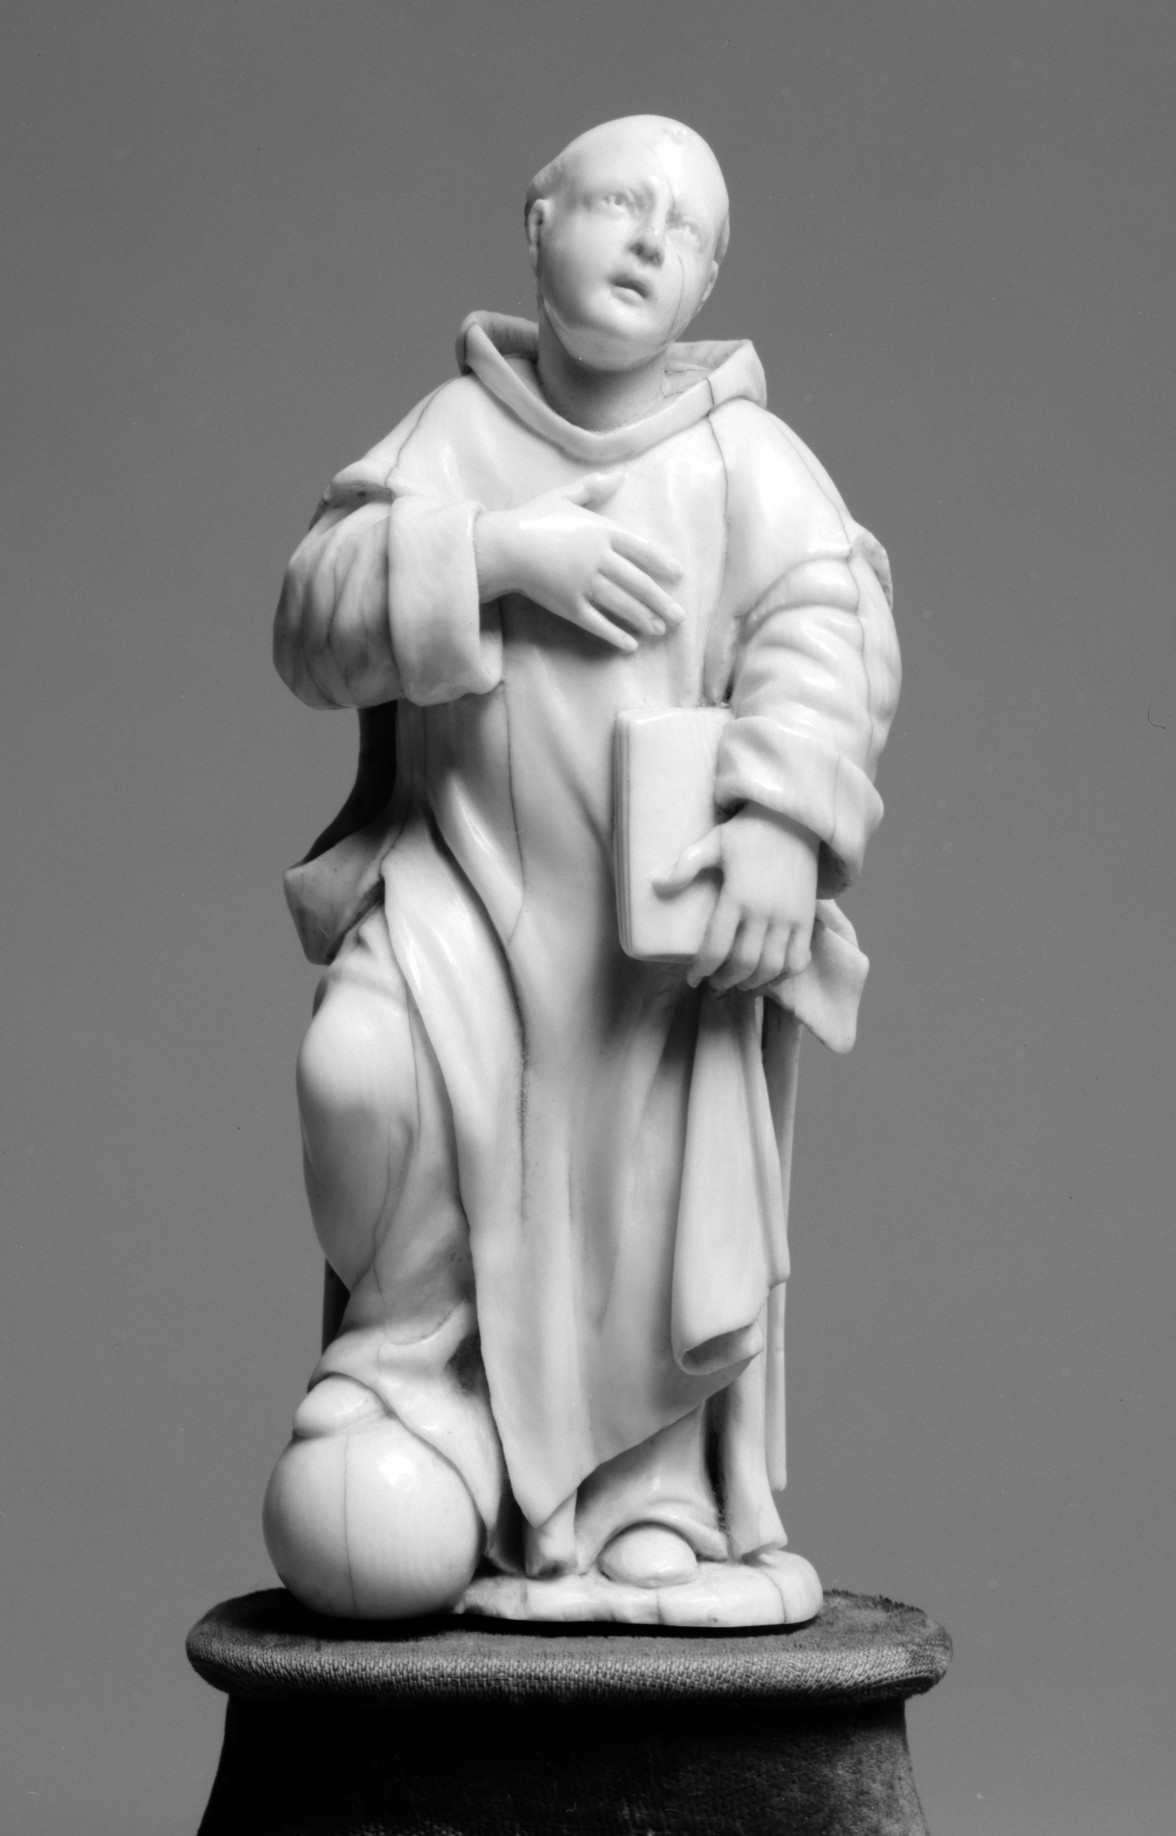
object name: statuette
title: Standing Male Saint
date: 1601-1800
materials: ivory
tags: men,saints